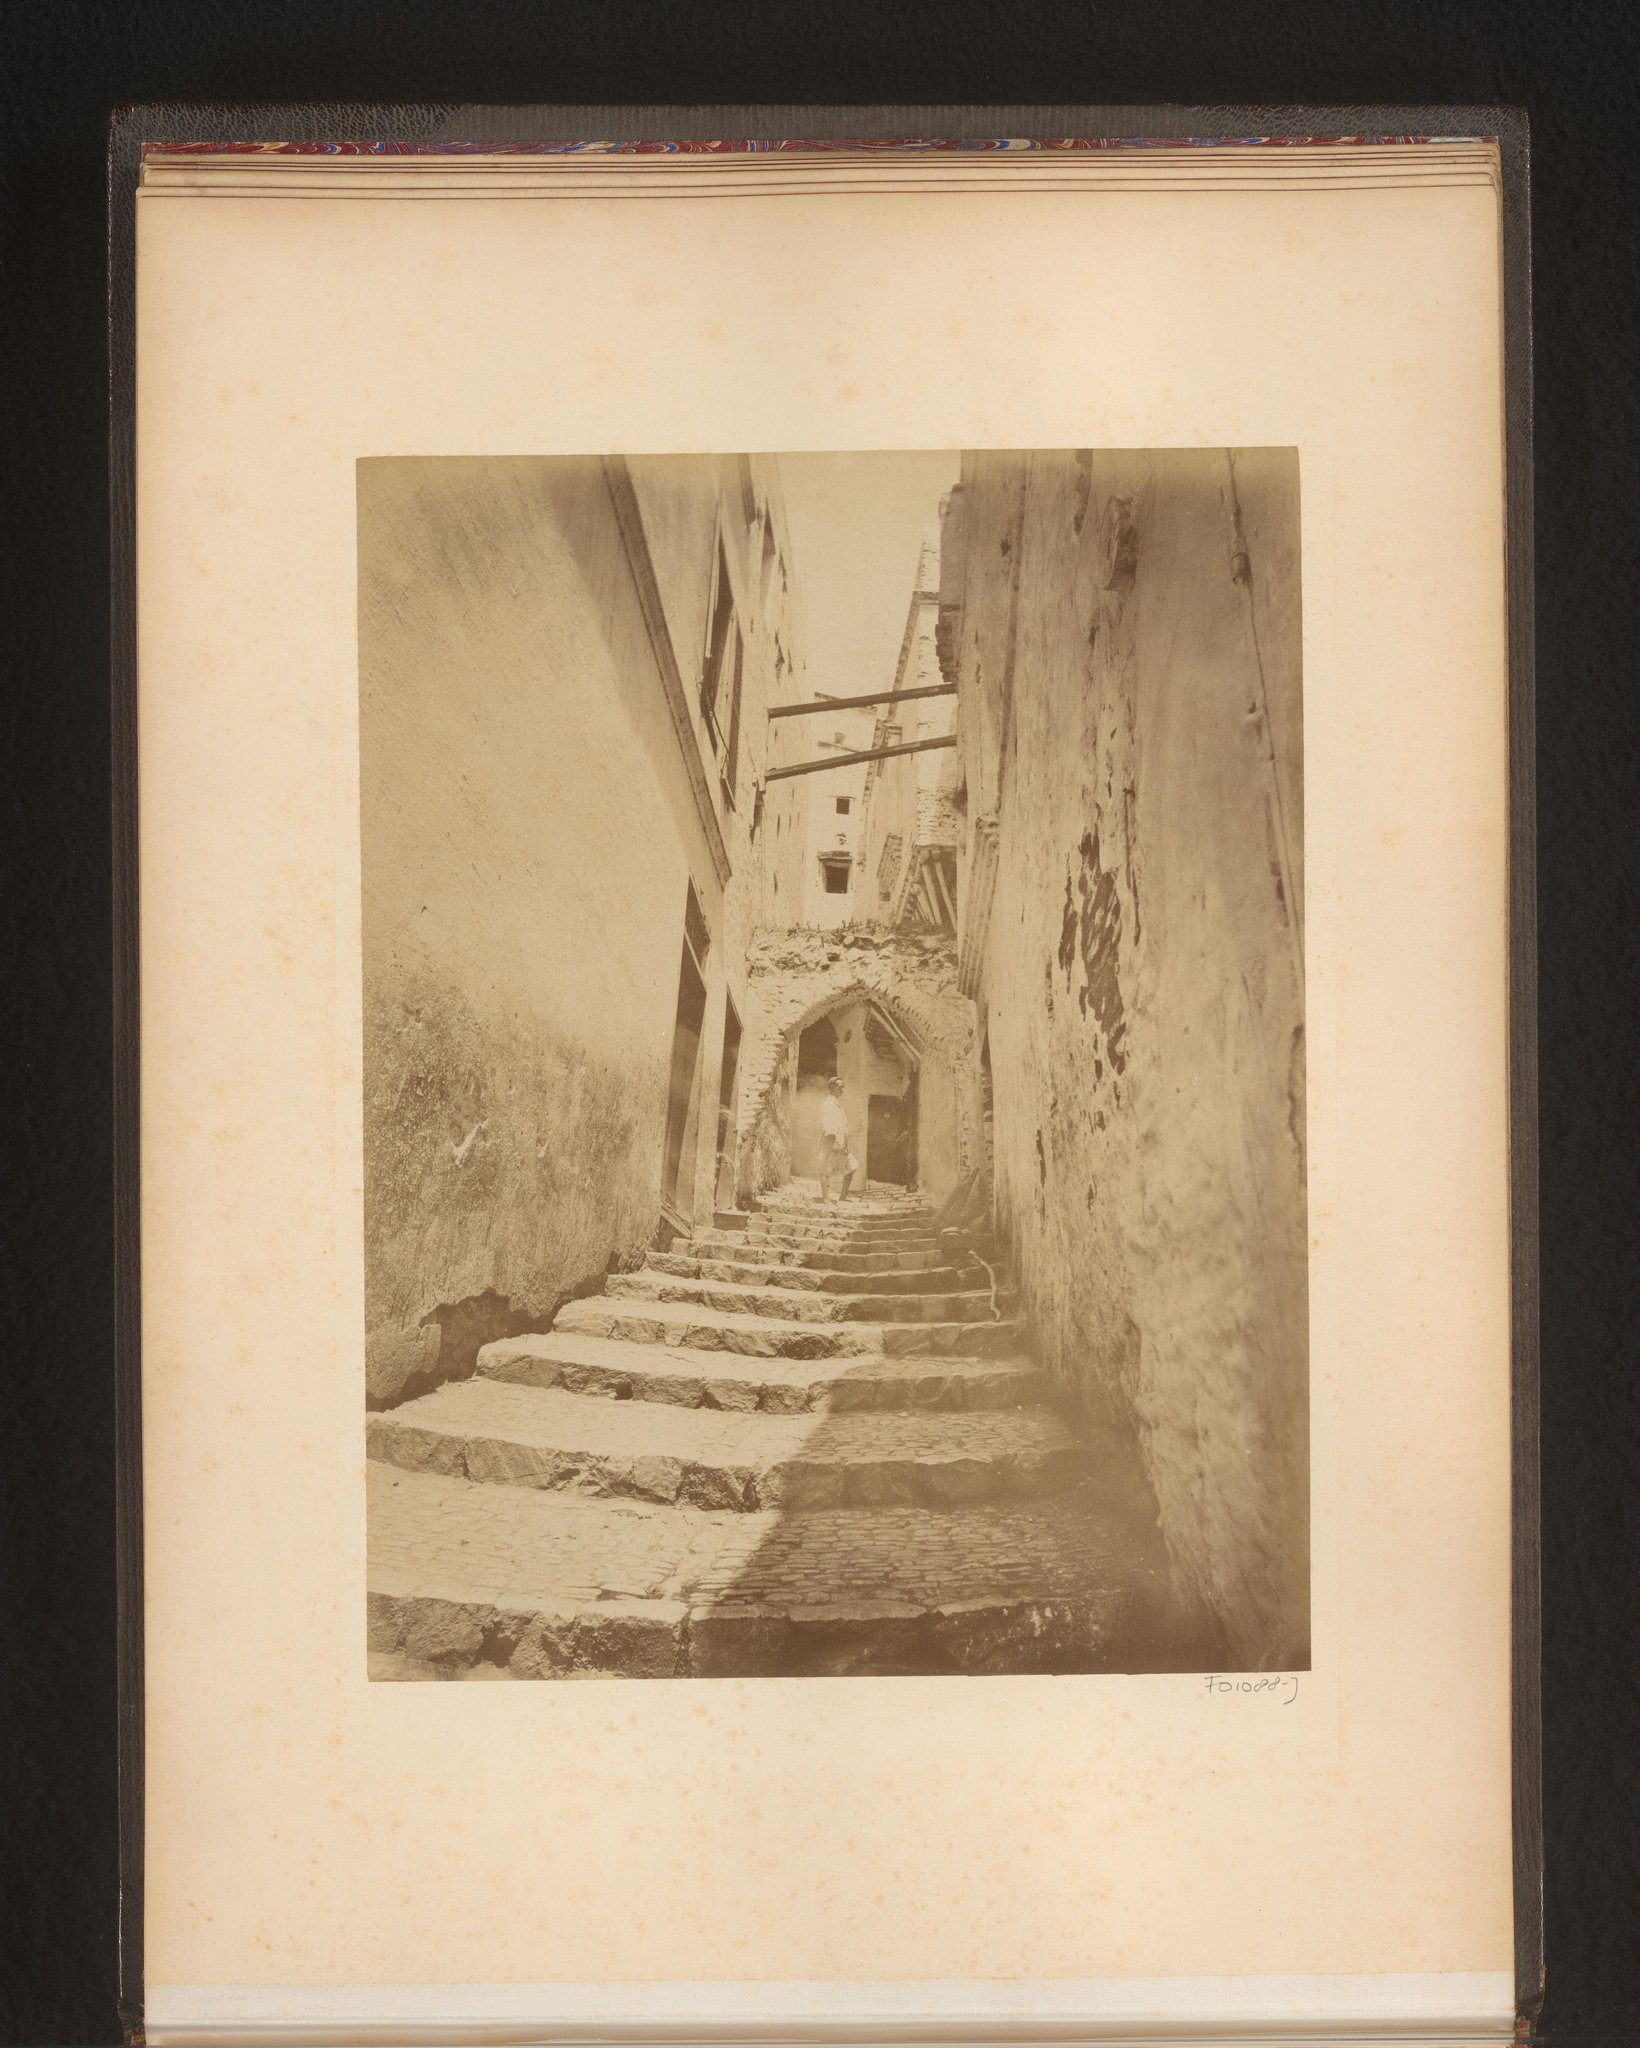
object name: album leaf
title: Man bovenaan een trap in een steeg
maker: Anonymous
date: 1880-1900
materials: photographic support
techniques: albumen print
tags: flight of steps, historical persons, lane, alley